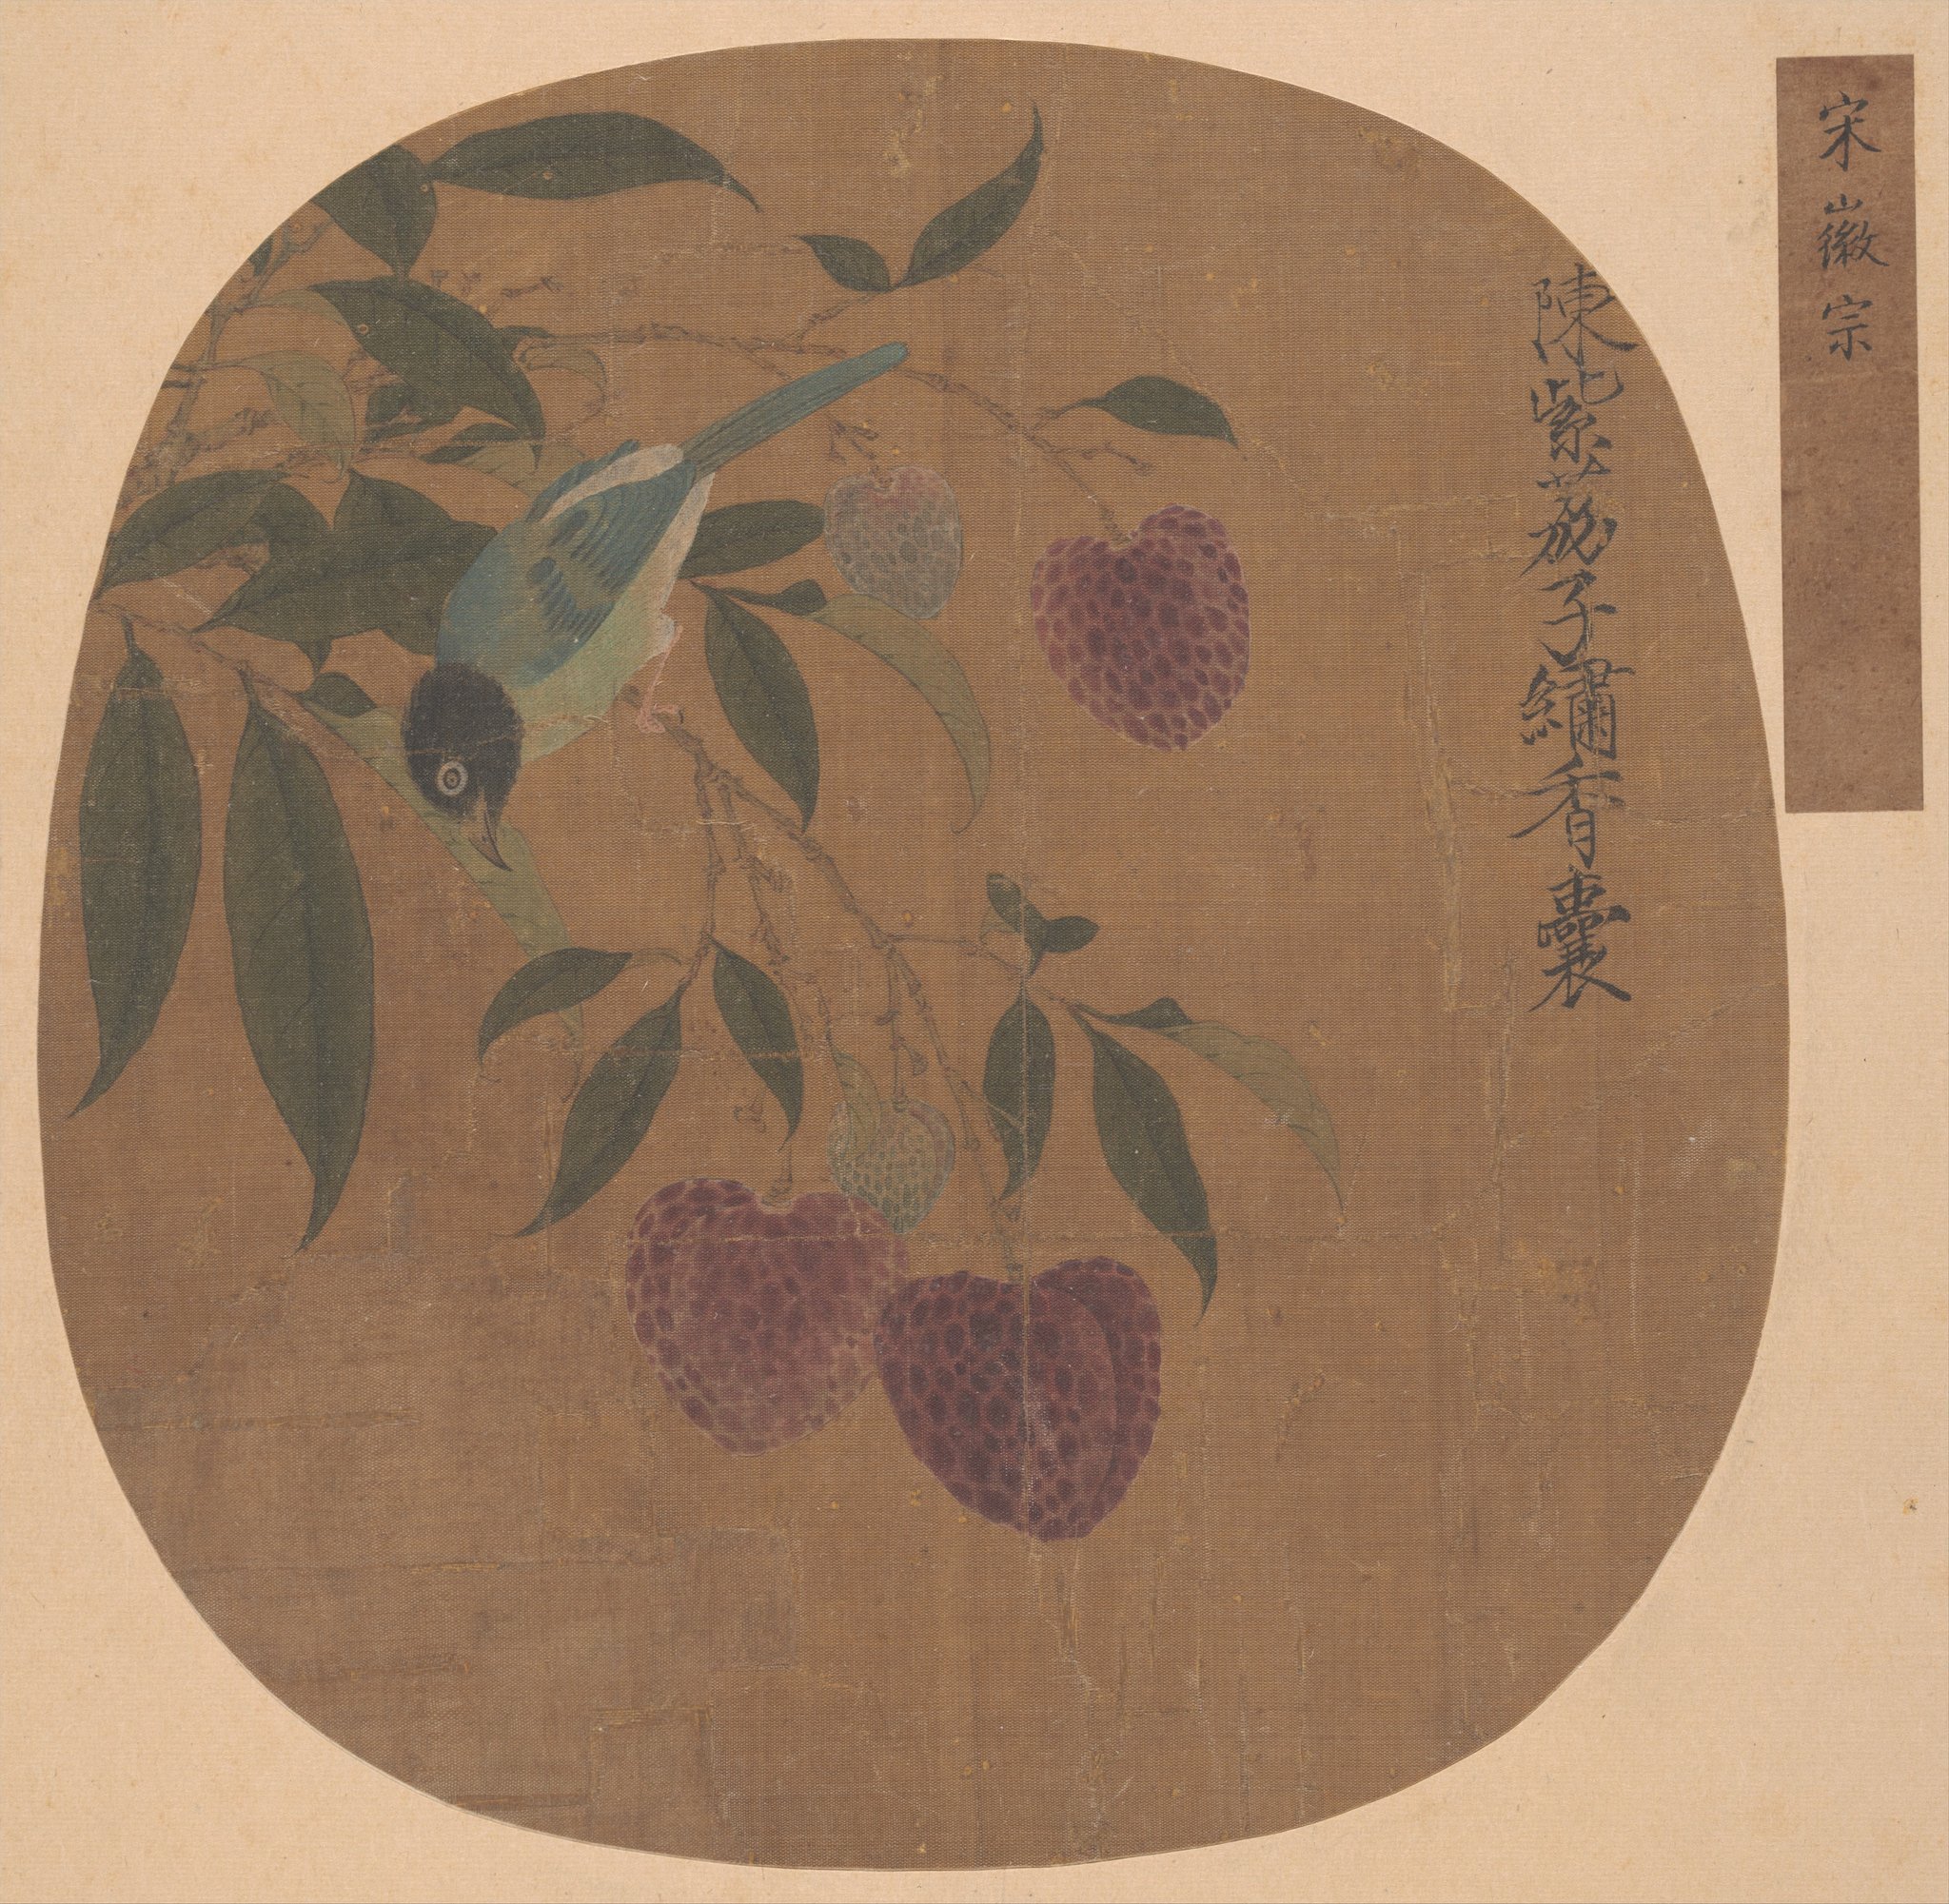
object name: fan mounted a an album leaf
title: Purple Lichees and Bird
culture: chinese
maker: unidentified artist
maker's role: artist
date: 960-1644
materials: ink, silk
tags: birds,fruit